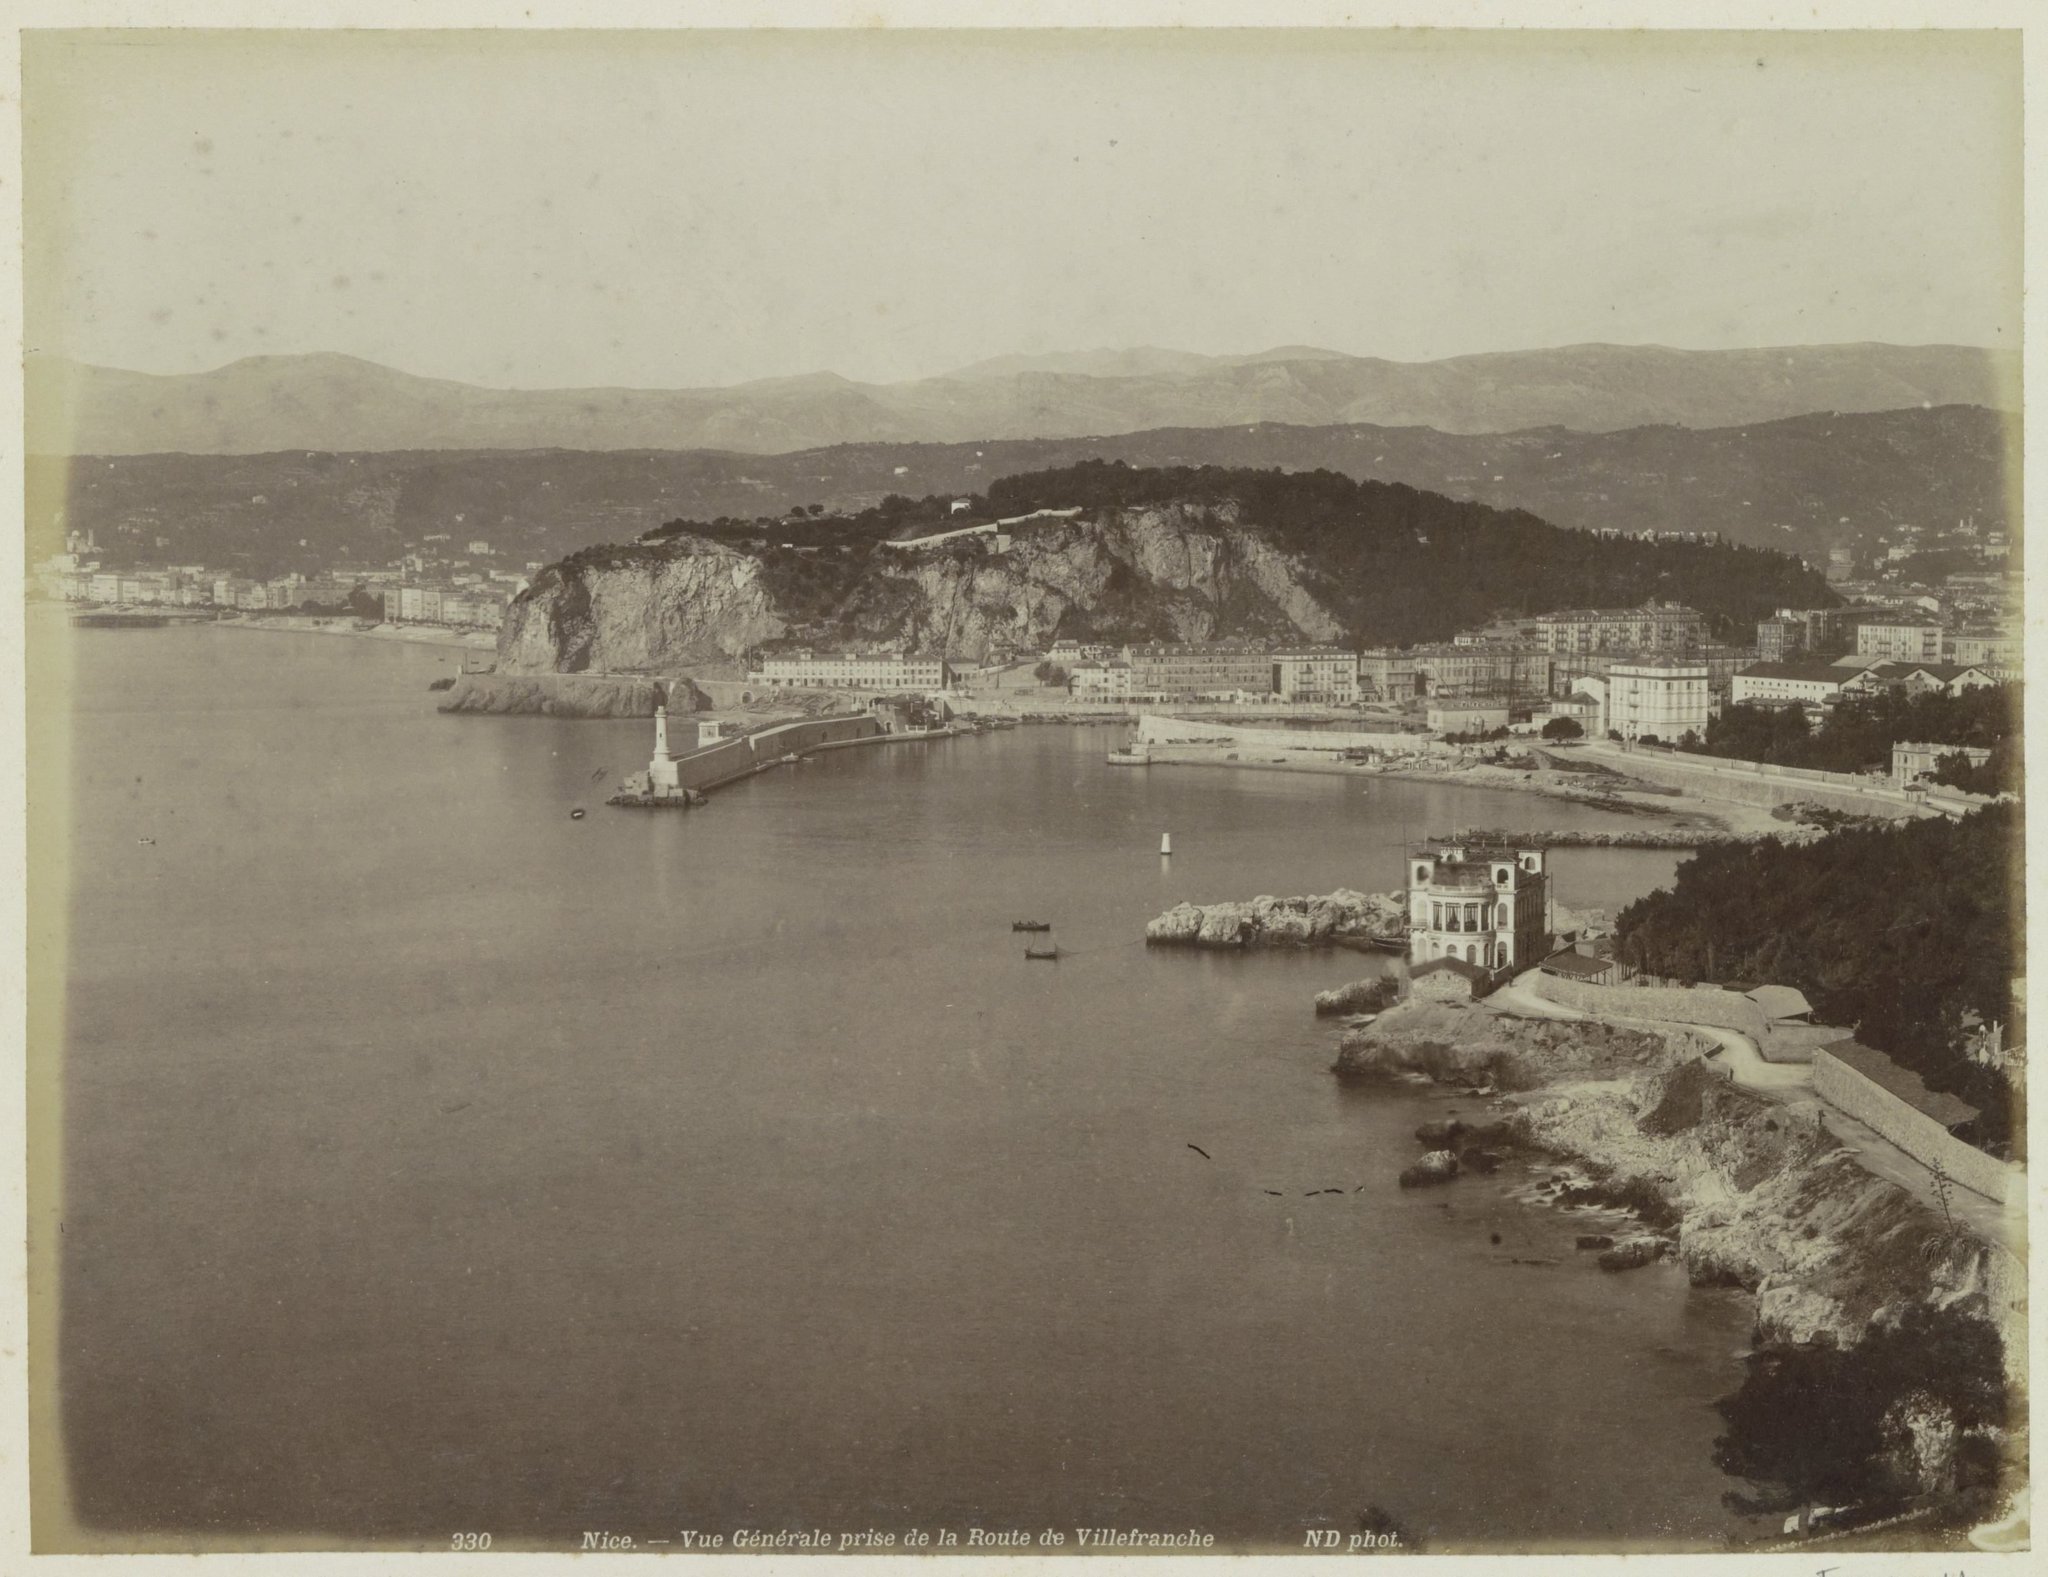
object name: photograph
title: Nice, de haven en het achterland gezien vanuit het zuidoosten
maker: étienne neurdein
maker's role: publisher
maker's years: 1832-1918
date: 1883-1888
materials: paper, photographic support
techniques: albumen print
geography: nice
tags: prospect of city, town panorama, silhouette of city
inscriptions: negative number: ‘330’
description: Onderdeel van Reisalbum met foto's van bezienswaardigheden in Italië en Frankrijk.